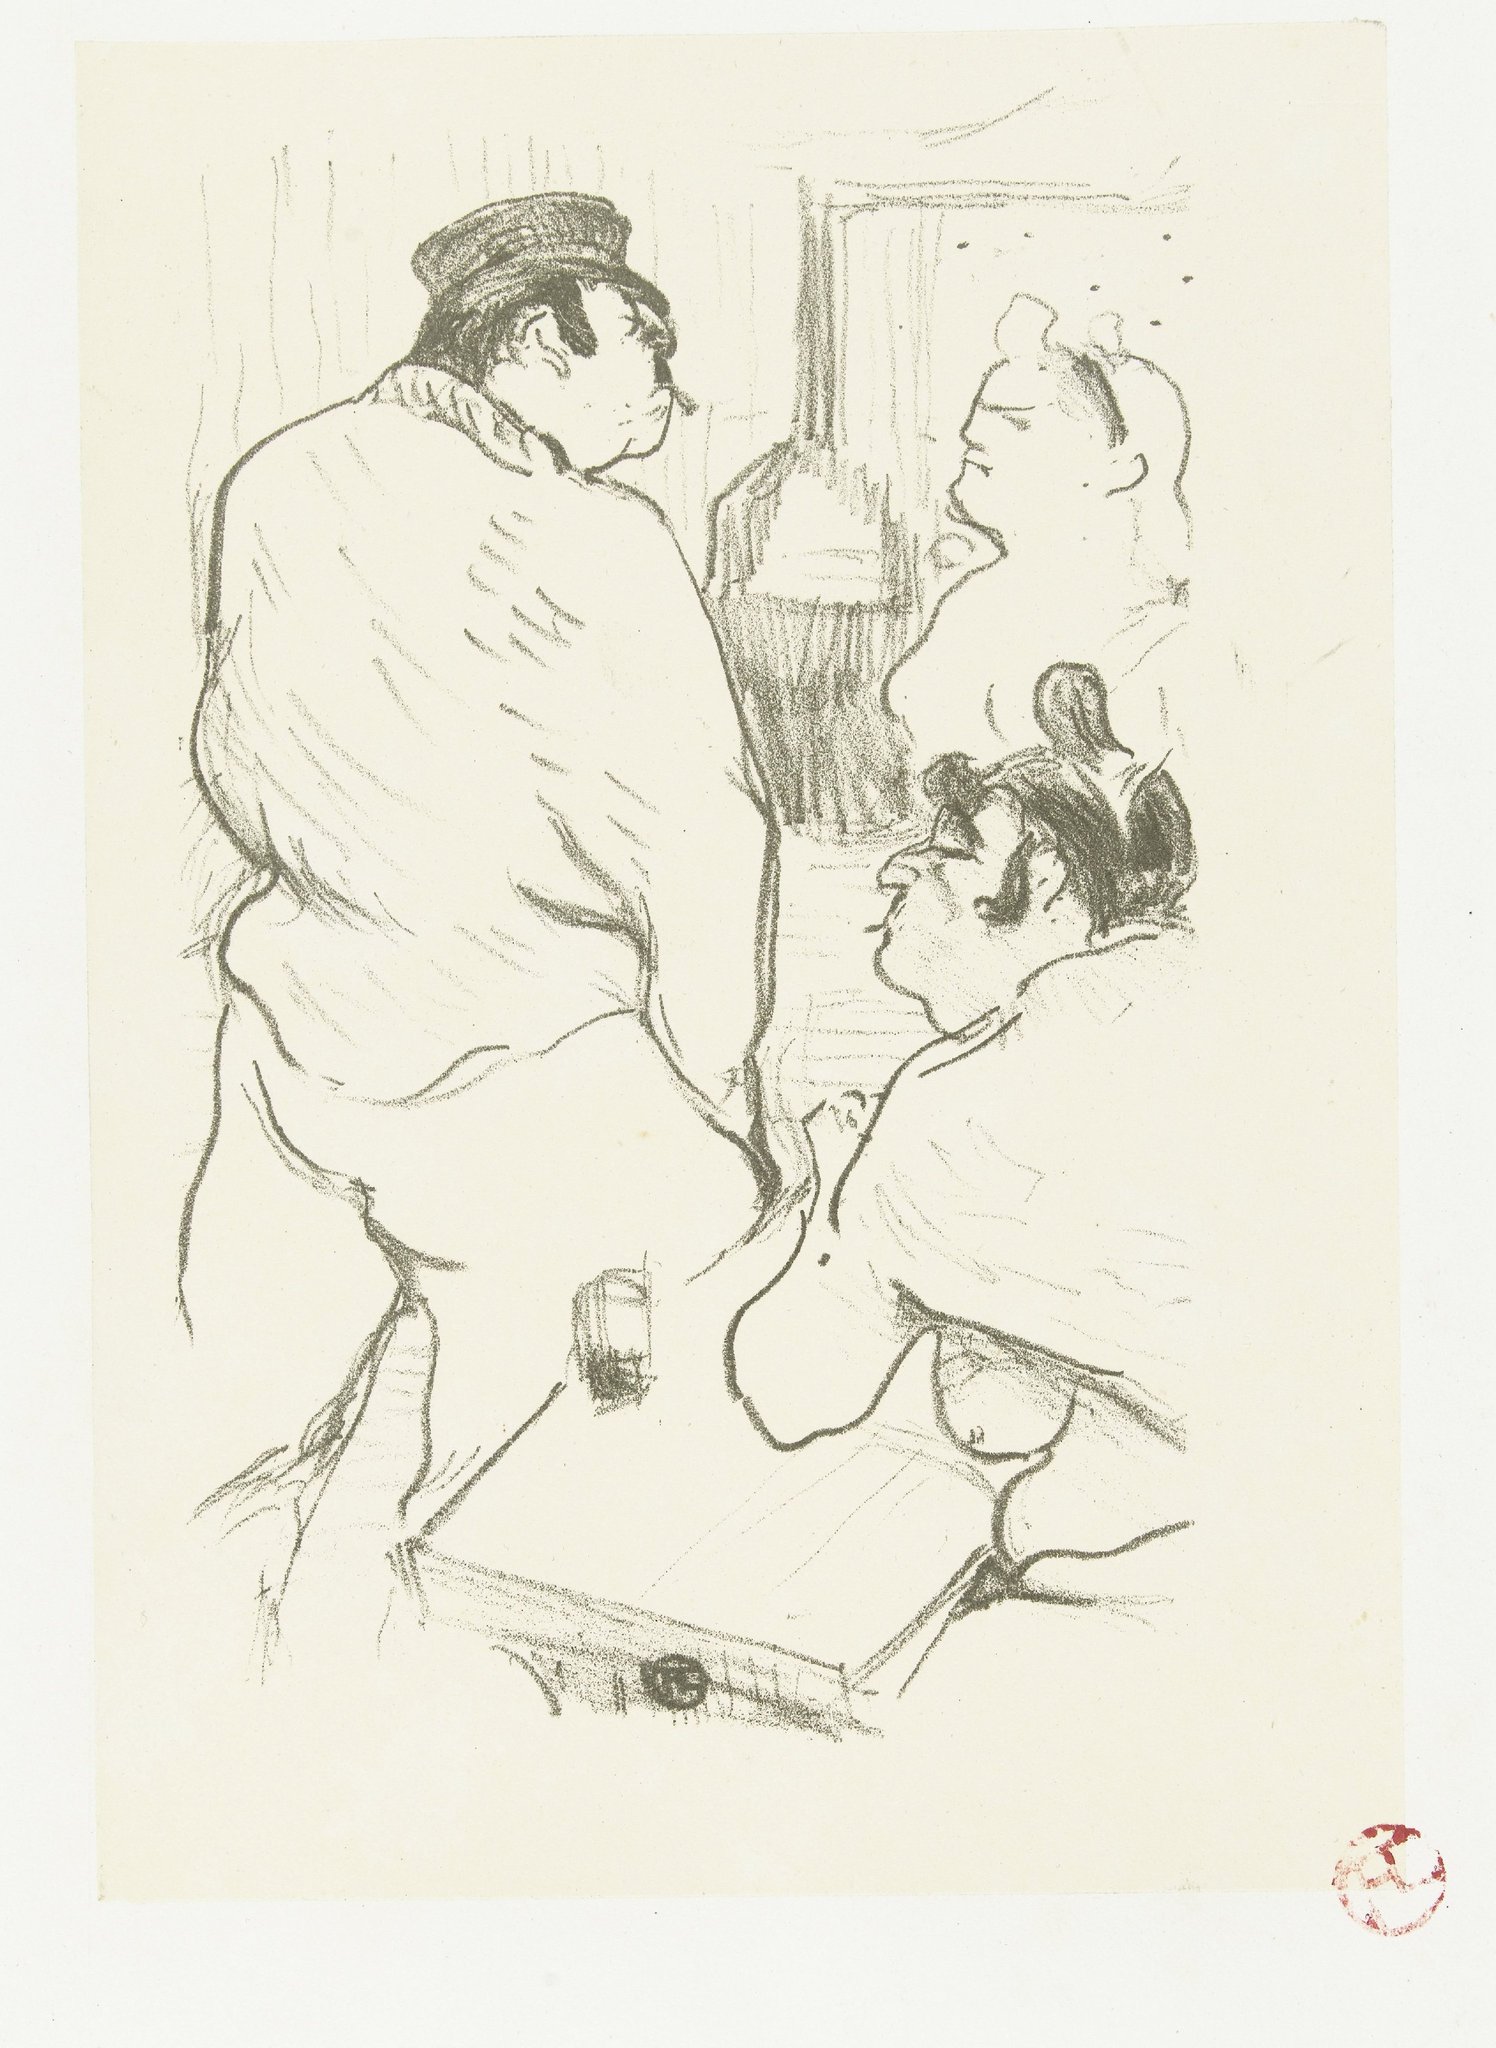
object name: print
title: La Terreur de Grennelle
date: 1894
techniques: printmaking, printing, lithograph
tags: brothel, whore, prostitute, male sex; man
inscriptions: stamp: Lugt 1338, collector's mark: Lugt 2760, collector's mark: Lugt 2228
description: Lithografie gebruikt voor omslag van muziekblad La terreur de Grenelle, G. Ondet (uitgever), Parijs 1894.